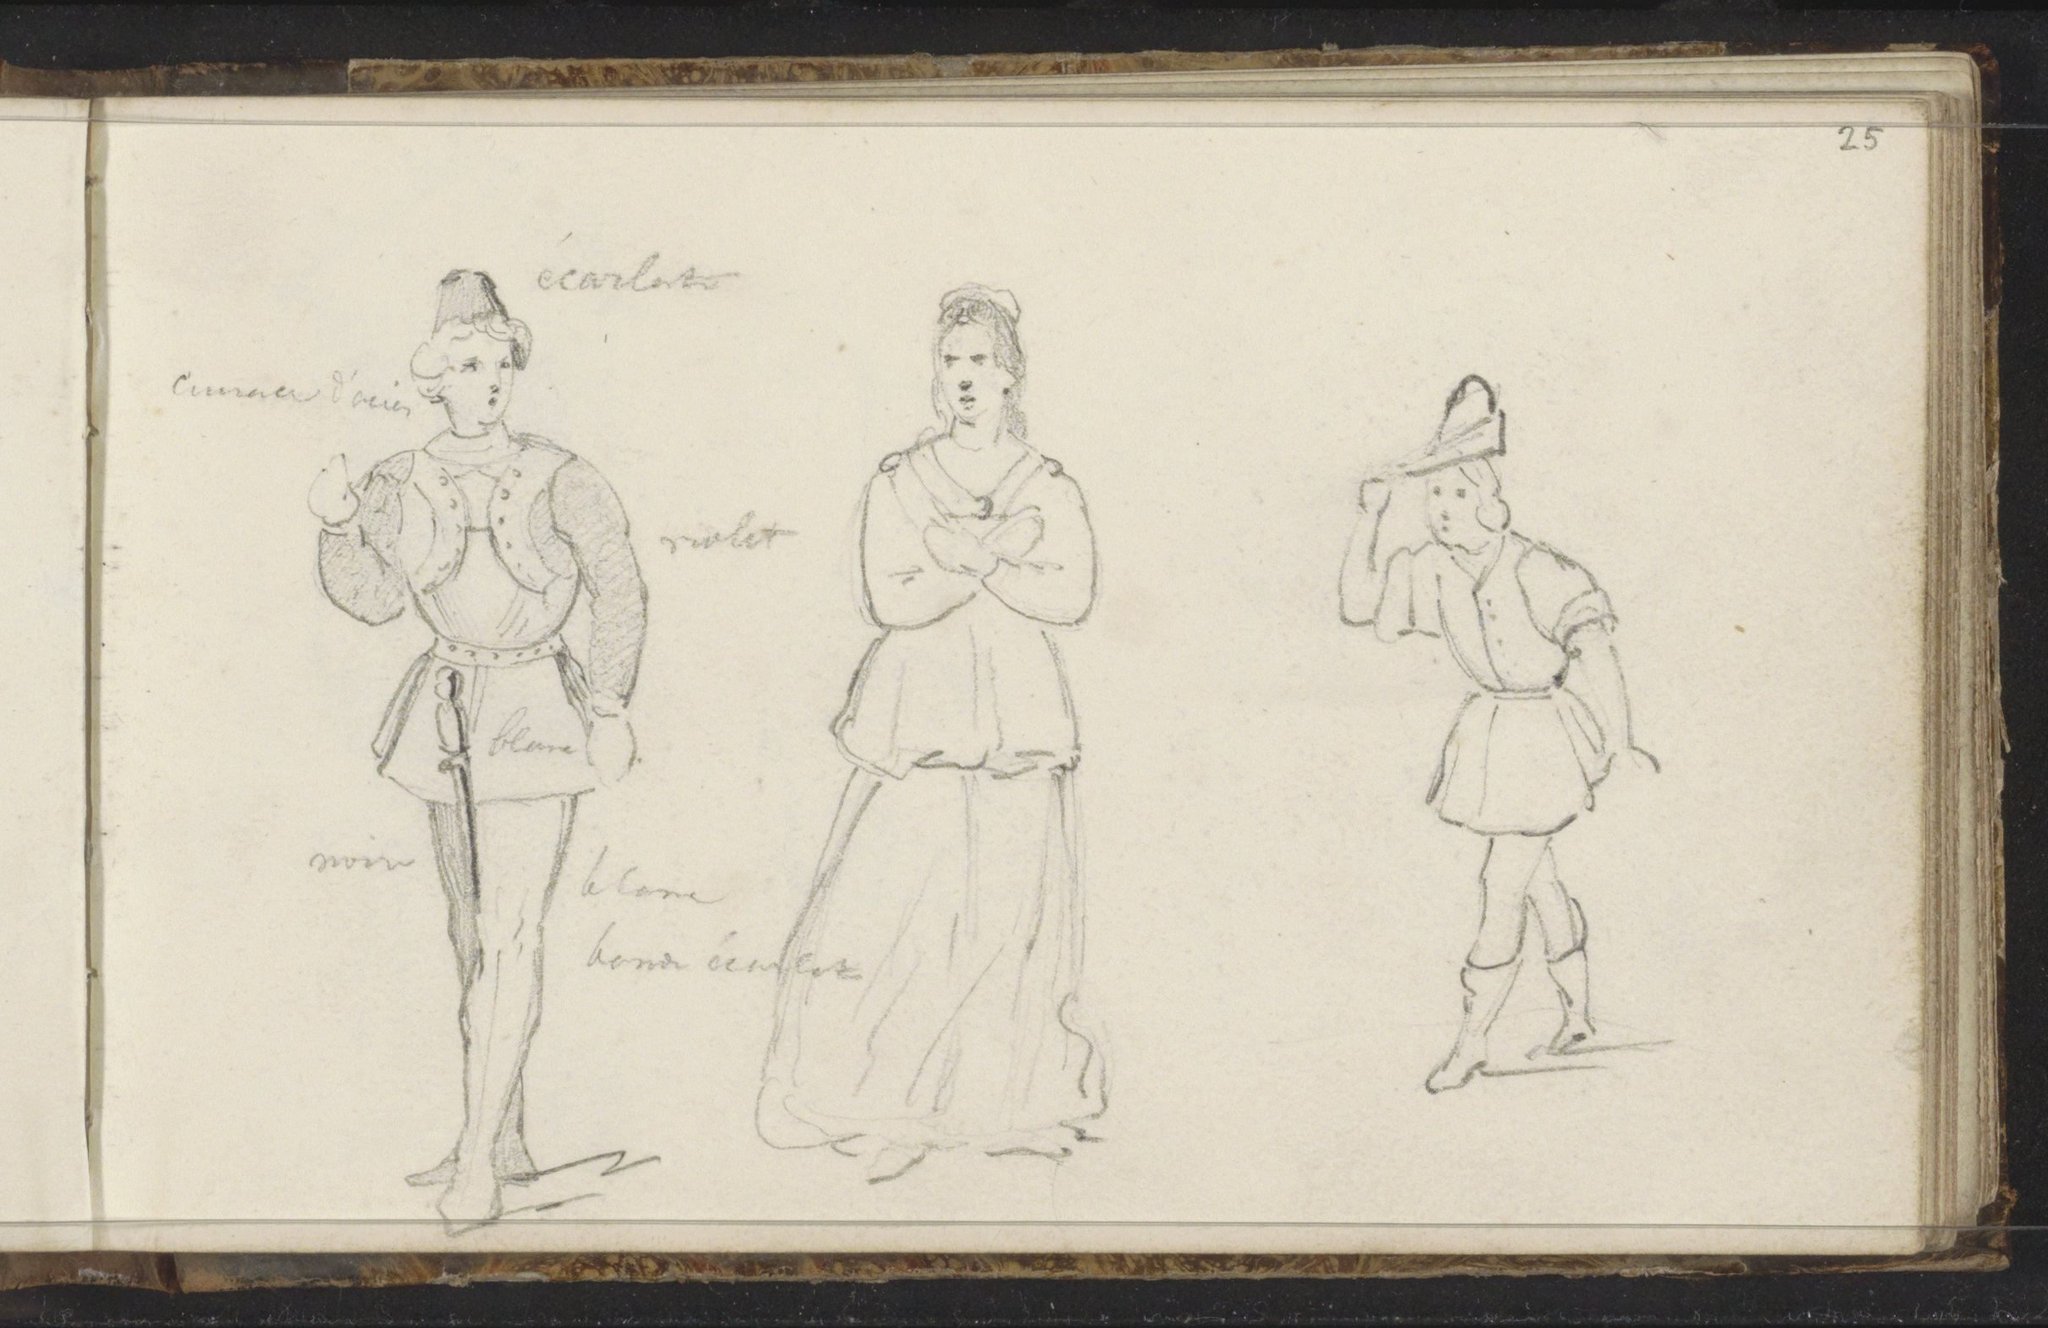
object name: sketchbook leaf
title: Man in harnas en twee figuren in historisch kostuum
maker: willem hendrik schmidt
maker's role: draughtsman, painter, print maker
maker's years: 1809-1849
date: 1819-1849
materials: paper, pencil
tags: historical costume (+ women's clothes), armour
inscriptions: kleurnotitie, handgeschreven in potlood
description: Blad 25 recto uit een schetsboek met 60 bladen.